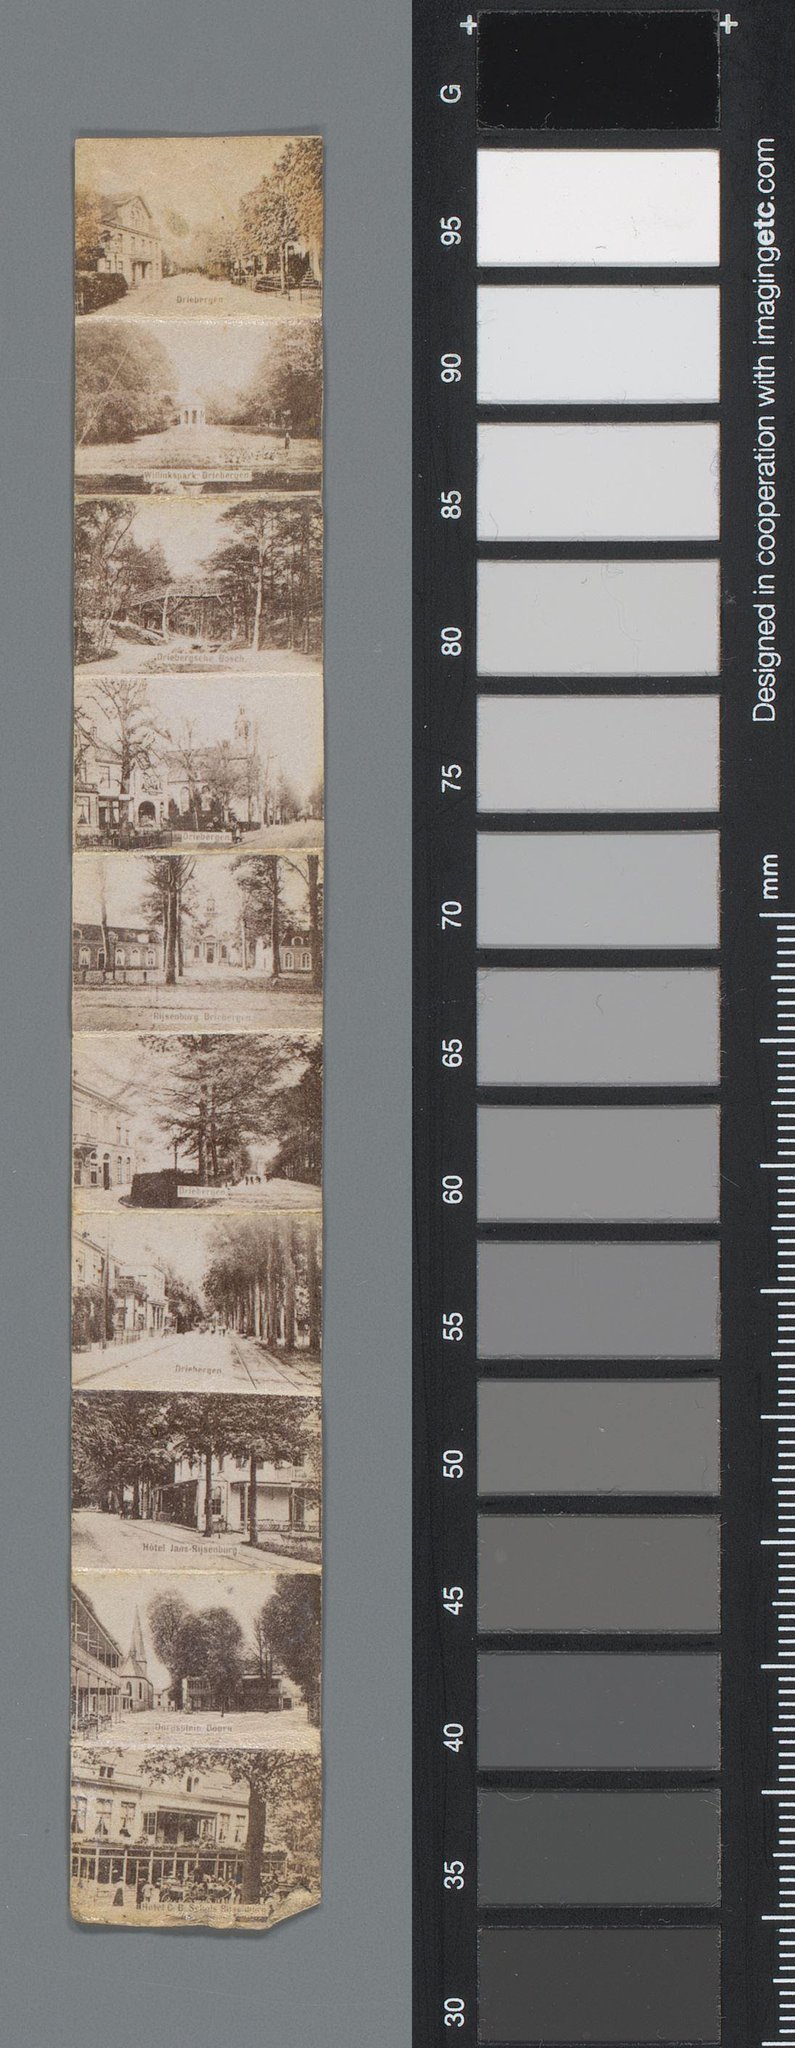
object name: photograph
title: Gezicht op Hotel C.B. Scholts aan Hoofdstraat 93 in Driebergen-Rijsenburg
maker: Anonymous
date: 1851-1900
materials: paper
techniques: albumen print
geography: driebergen-rijsenburg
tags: hotel, hostelry, inn